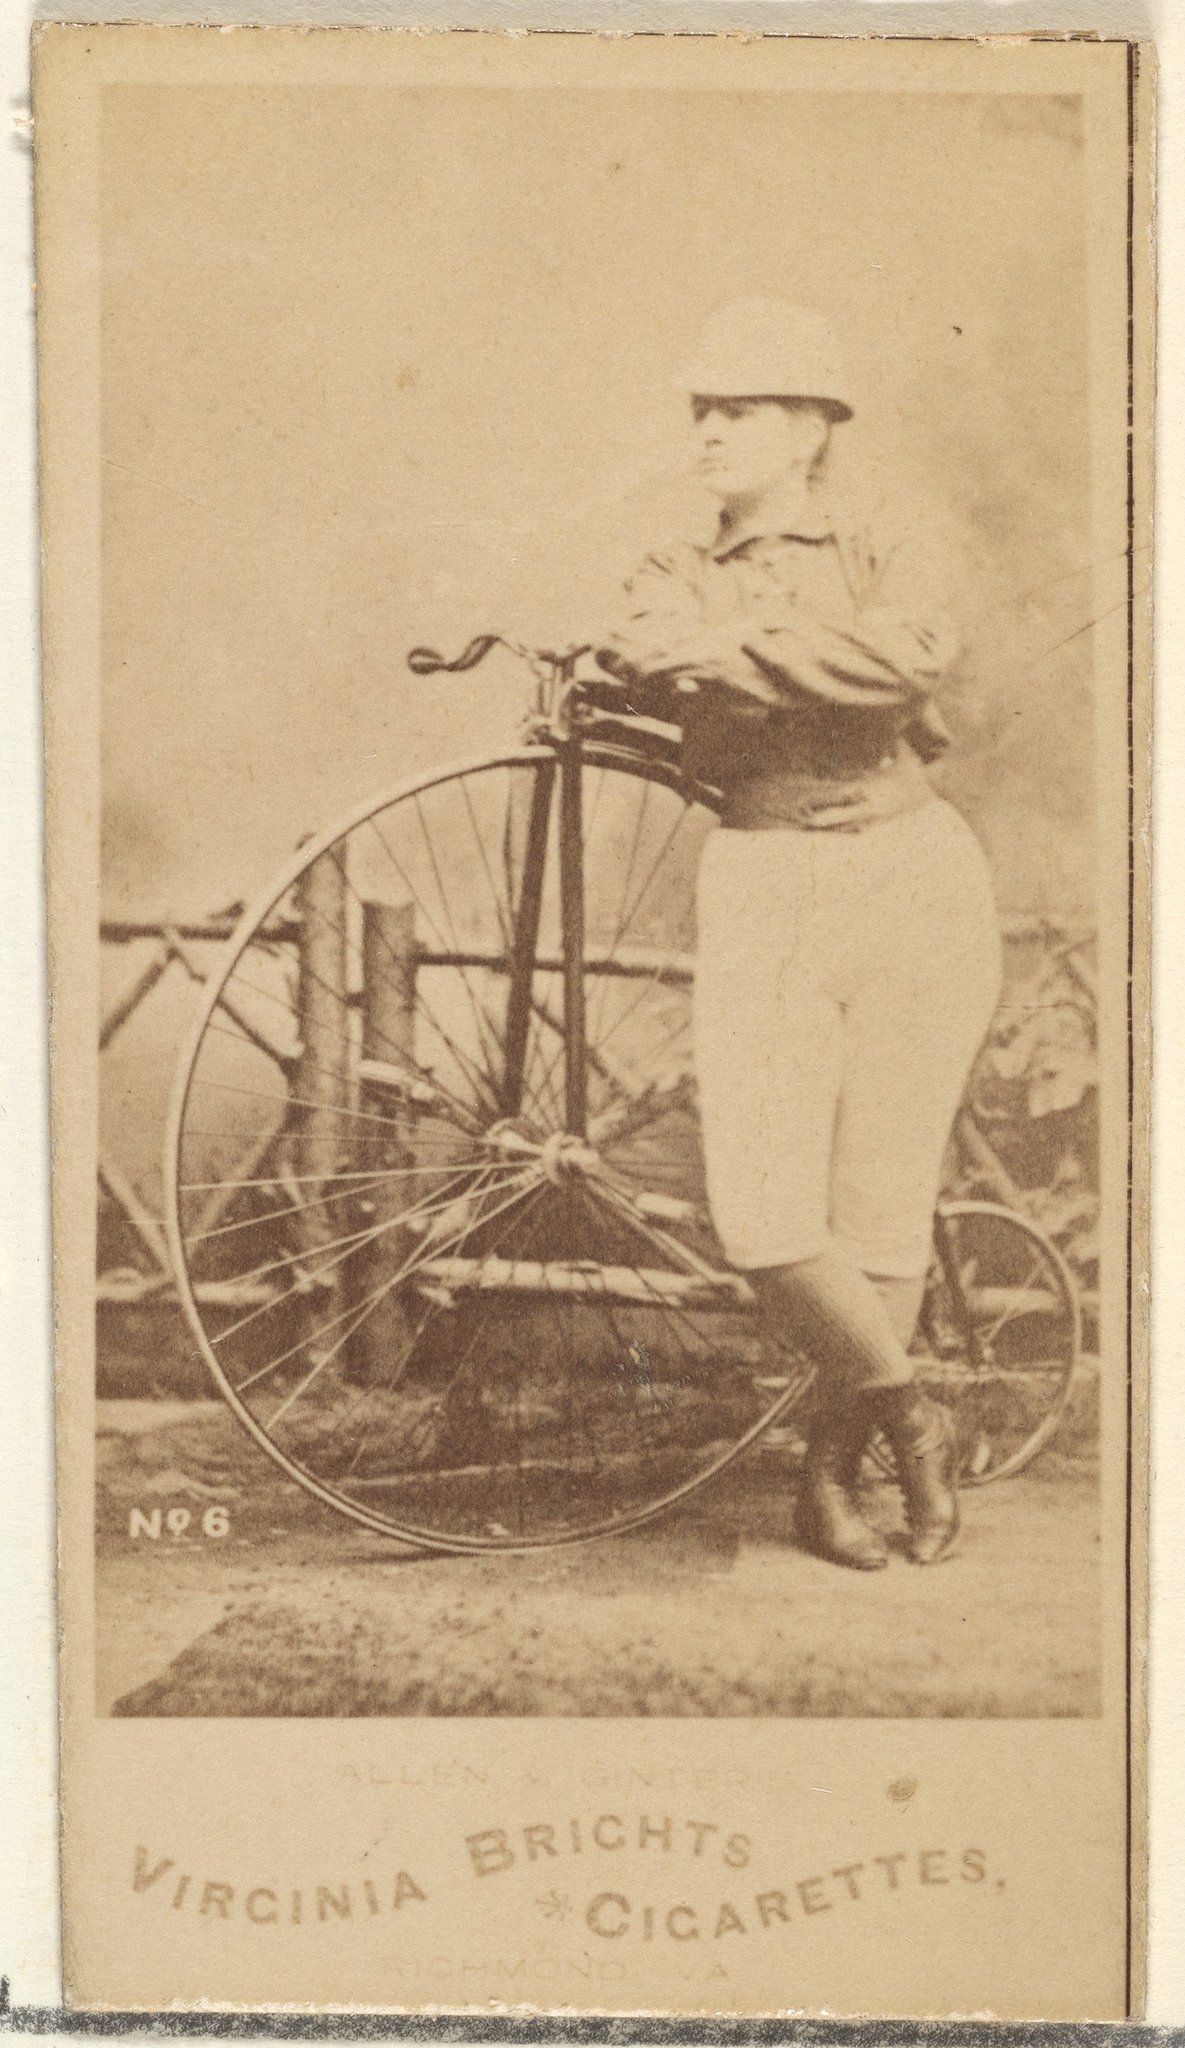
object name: photograph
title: Card 6, from the Girl Cyclists series (N49) for Virginia Brights Cigarettes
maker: allen & ginter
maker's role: publisher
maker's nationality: american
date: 1887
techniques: albumen silver print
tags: women,bicycles